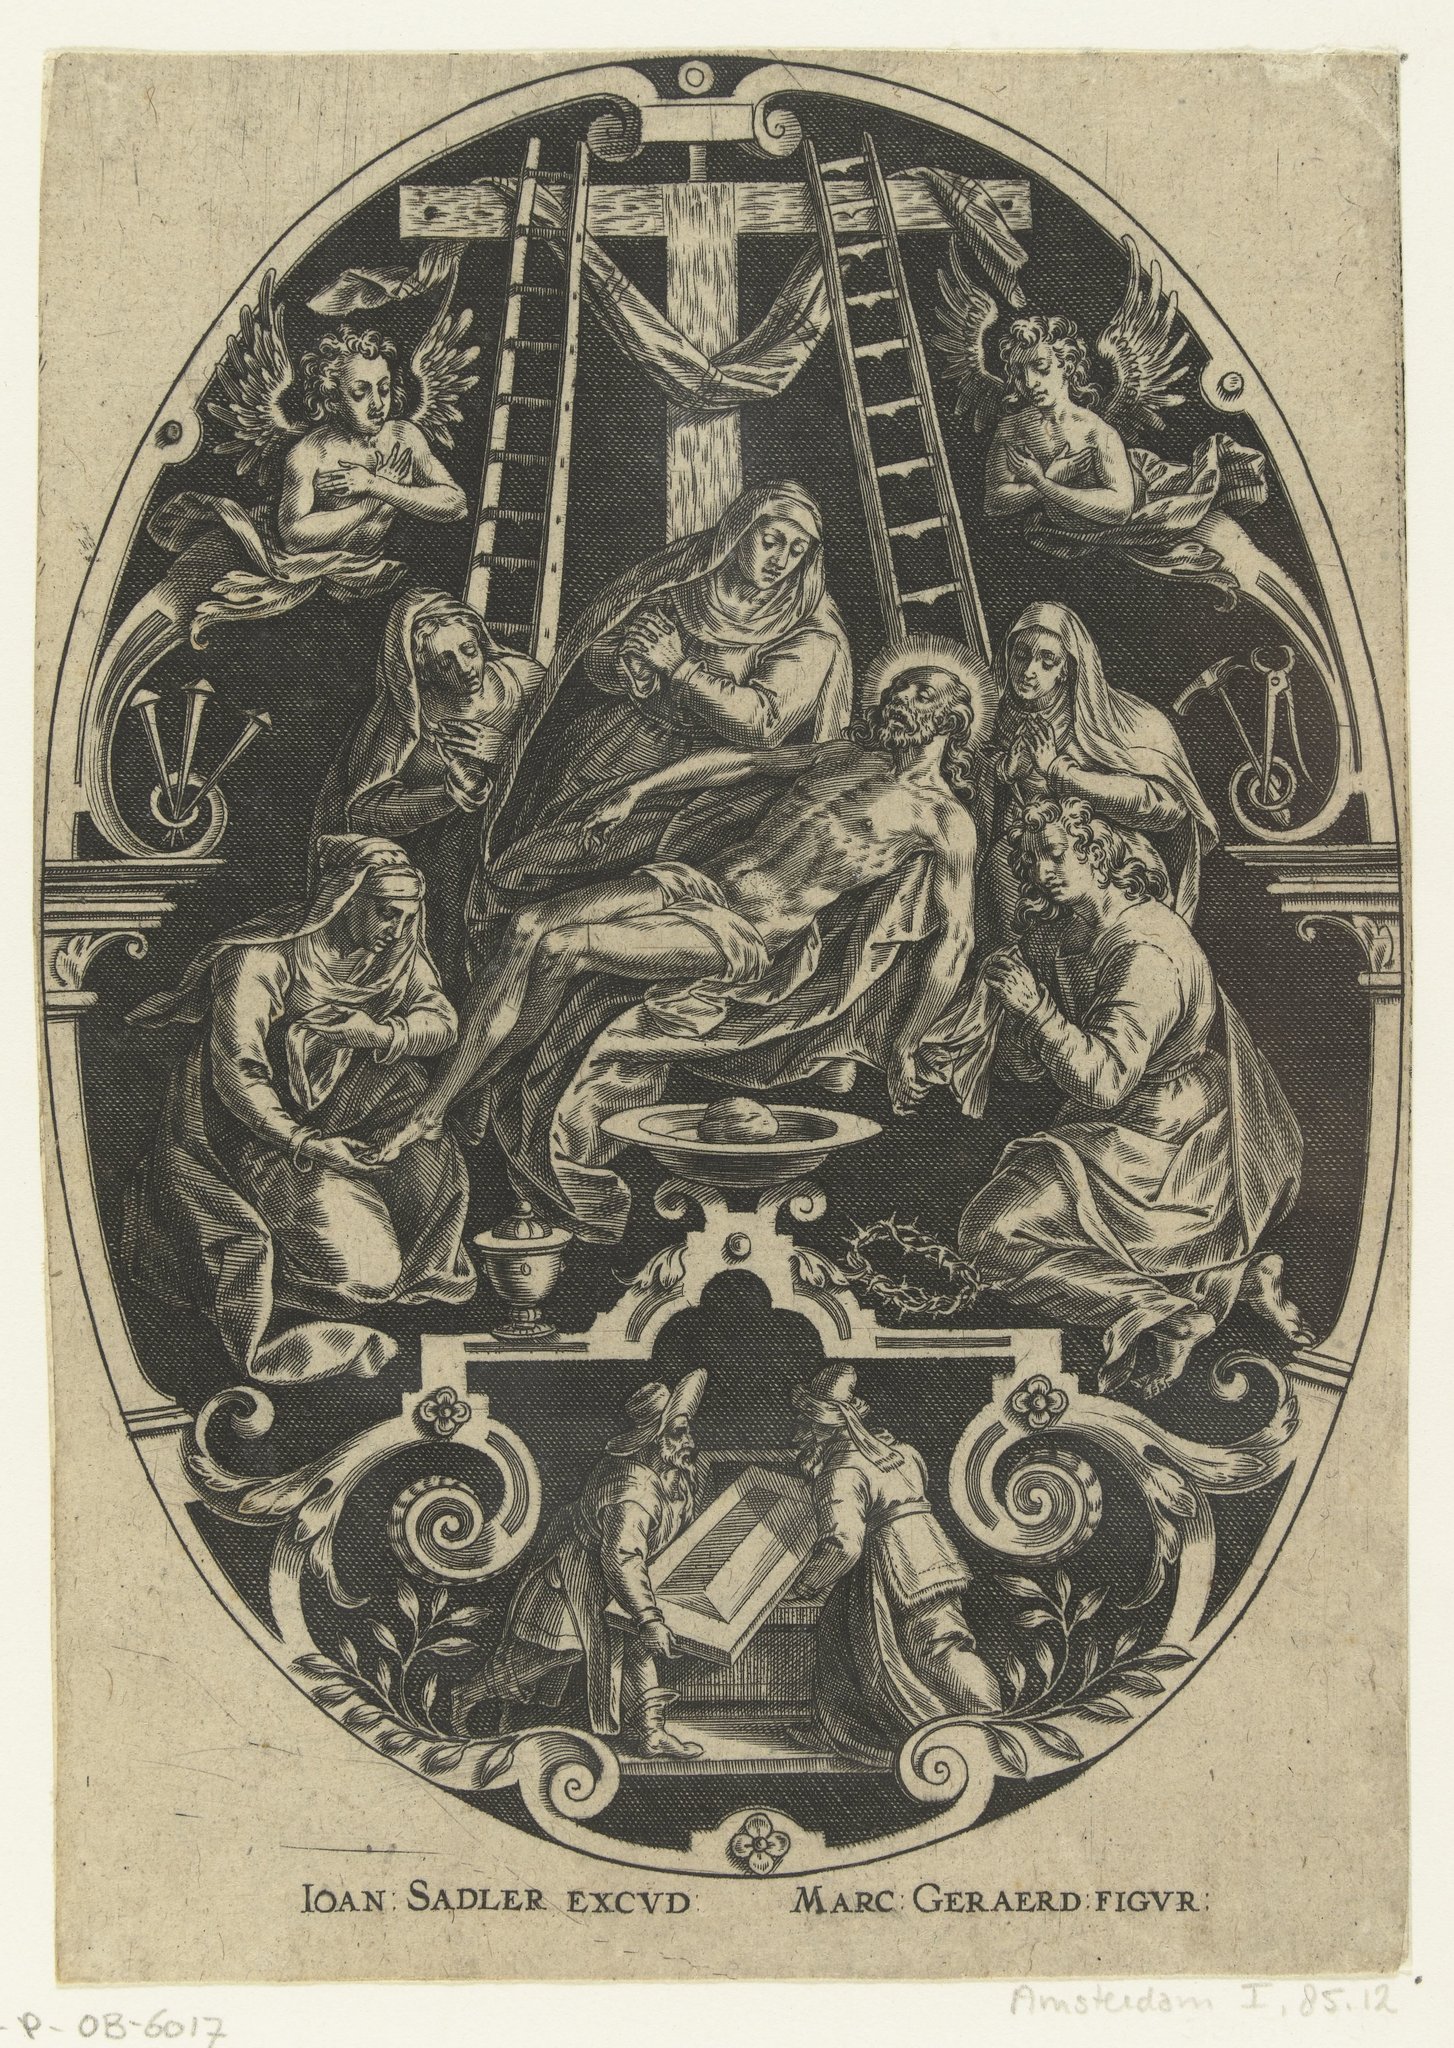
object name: print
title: Passio verbigenae quae redeptio Christ (...)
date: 1560-1600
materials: paper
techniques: engraving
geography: netherlands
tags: the mourning over the dead christ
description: De bewening van de gestorven Christus. Onderaan wordt het graf gesloten. Uit serie van 14 ovalen met grotesken waarin scènes uit de passie zijn afgebeeld. Gearceerde achtergrond.